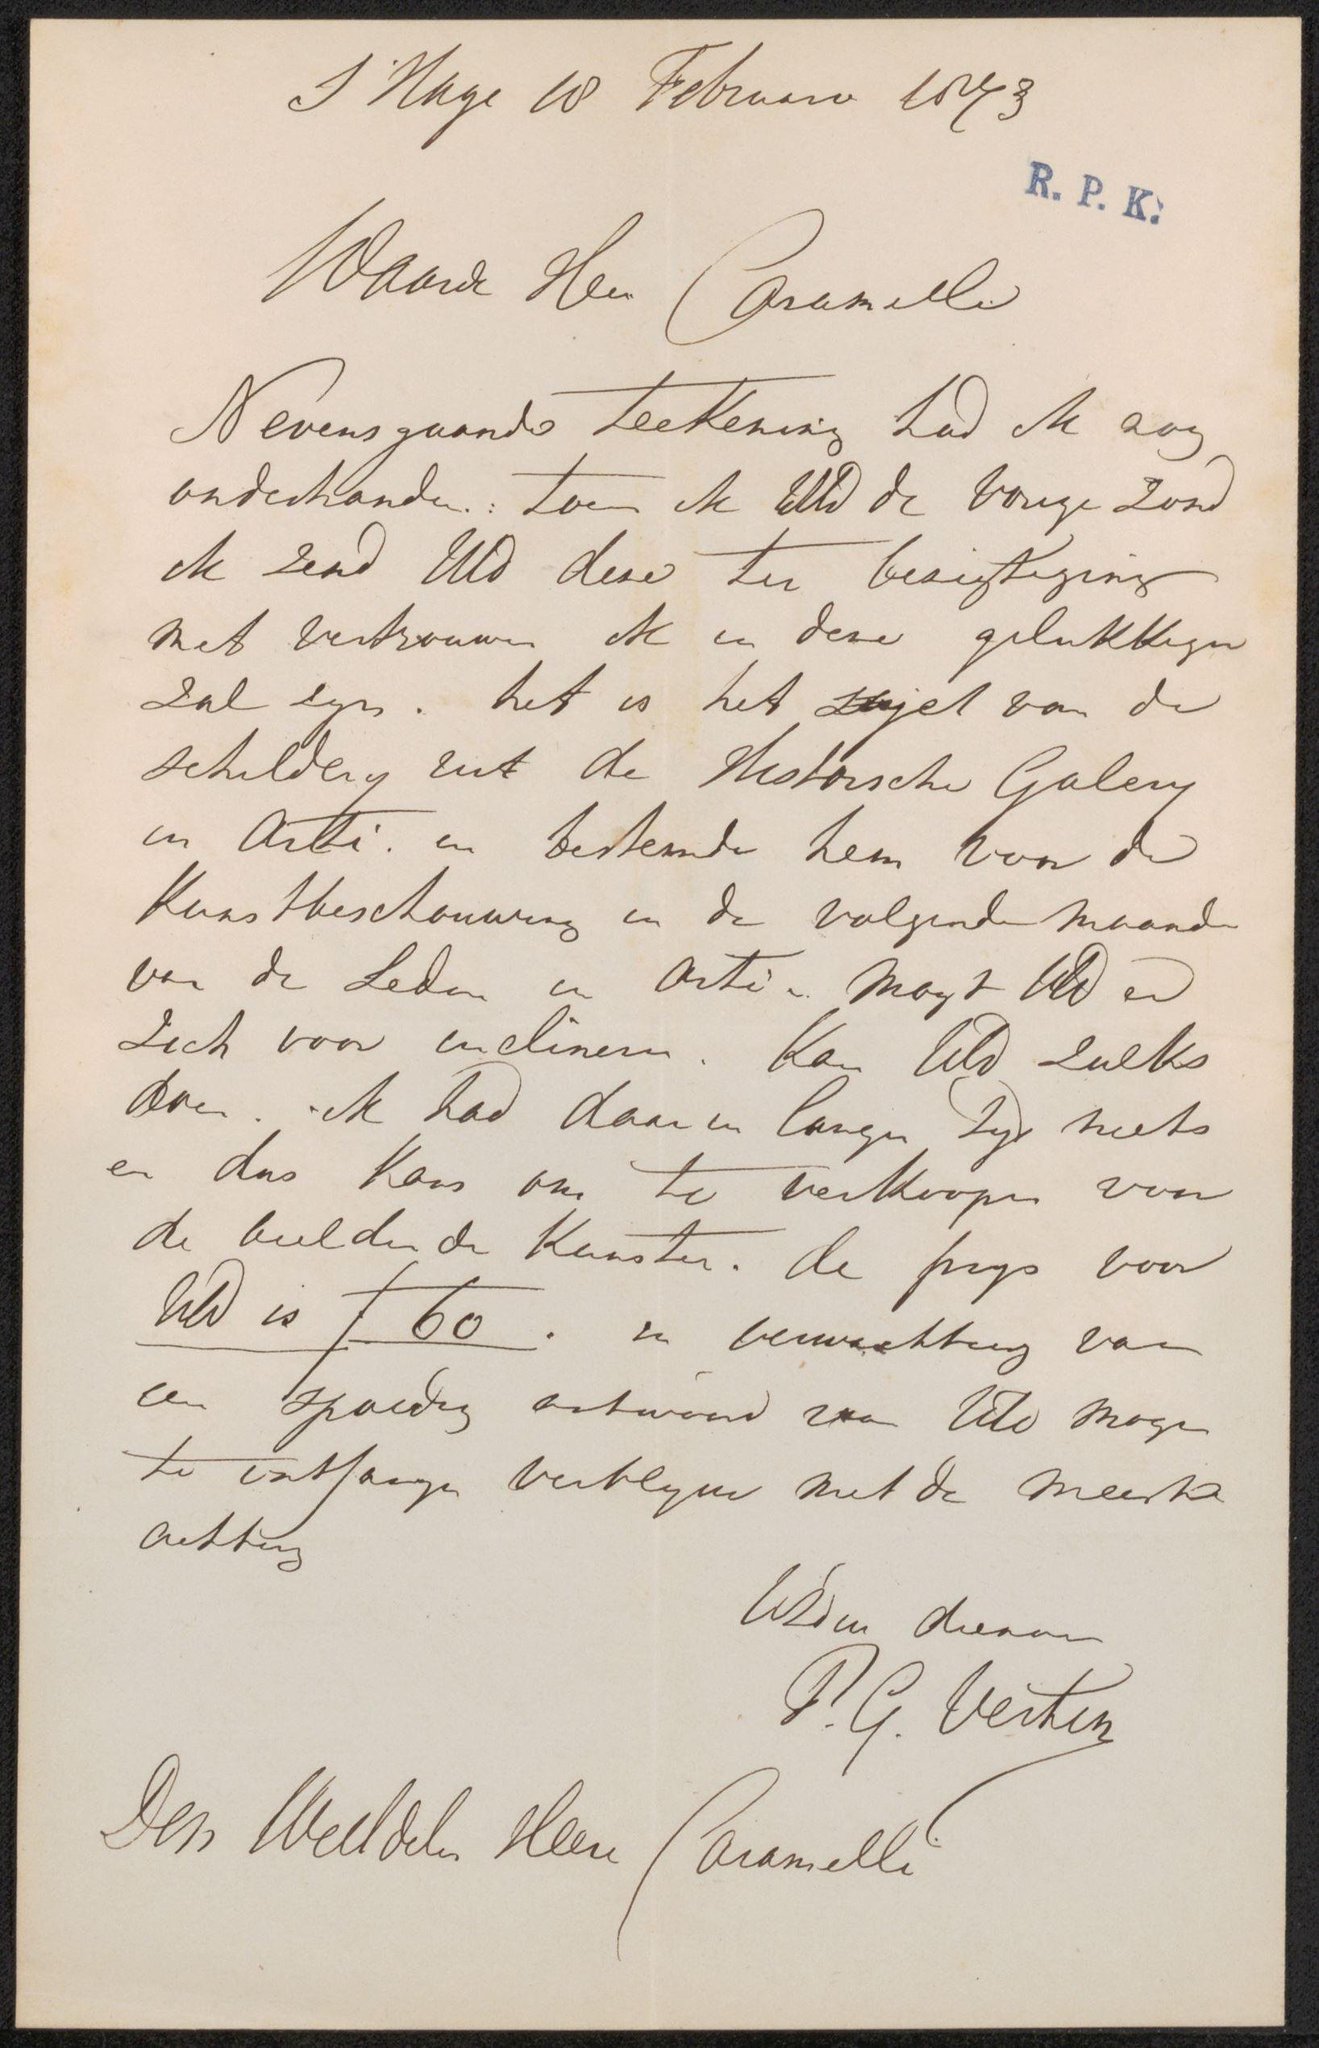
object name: letter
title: Brief aan Alberto Caramelli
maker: petrus gerardus vertin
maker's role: draughtsman, painter, print maker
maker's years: 1819-1893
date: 1873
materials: ink, paper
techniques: pen, writing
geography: the hague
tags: utrecht, amsterdam, publisher, alberto caramelli, criticizing and discussing art, art criticism, art trade, art shop, drawing, painting (including book-illumination, miniature-painting), money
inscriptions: collector's mark: Lugt 2233